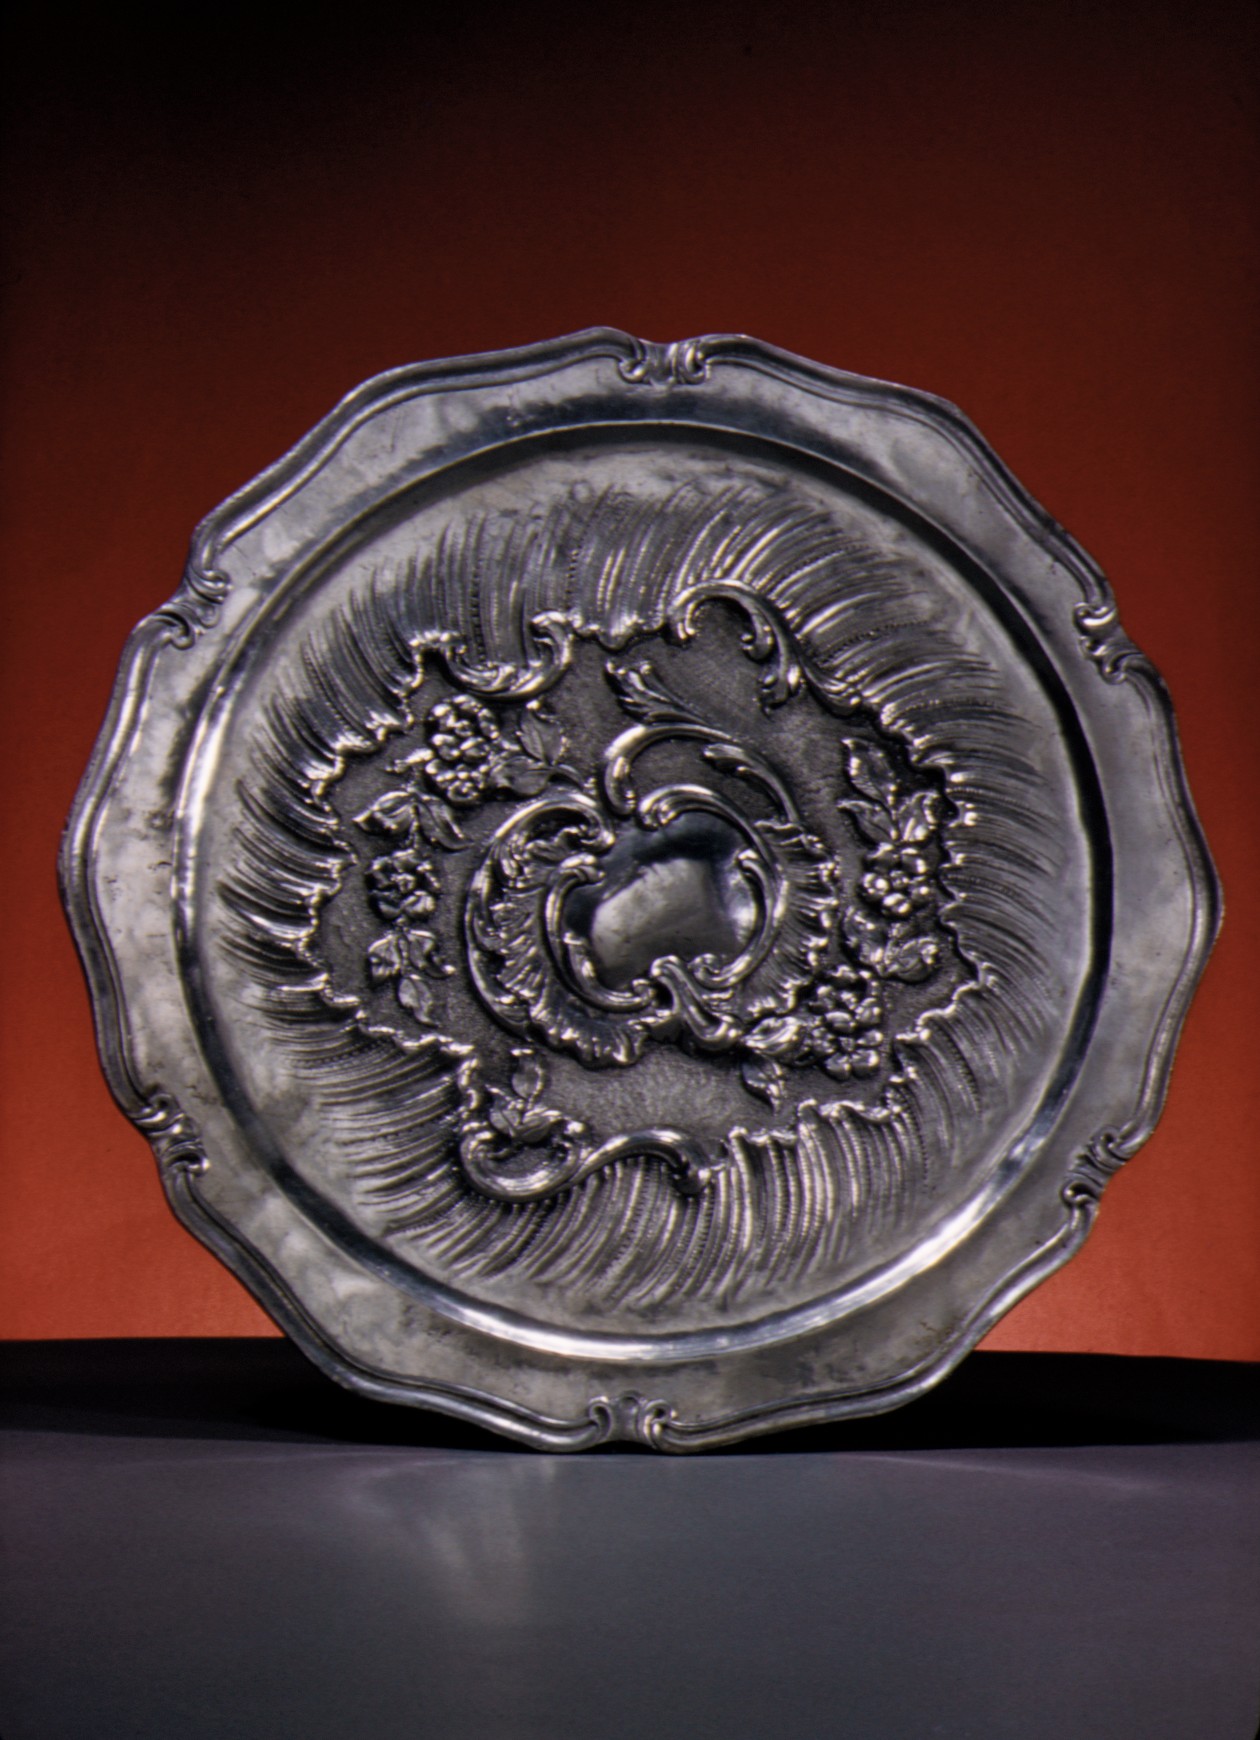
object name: salver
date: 1701-1800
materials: pewter